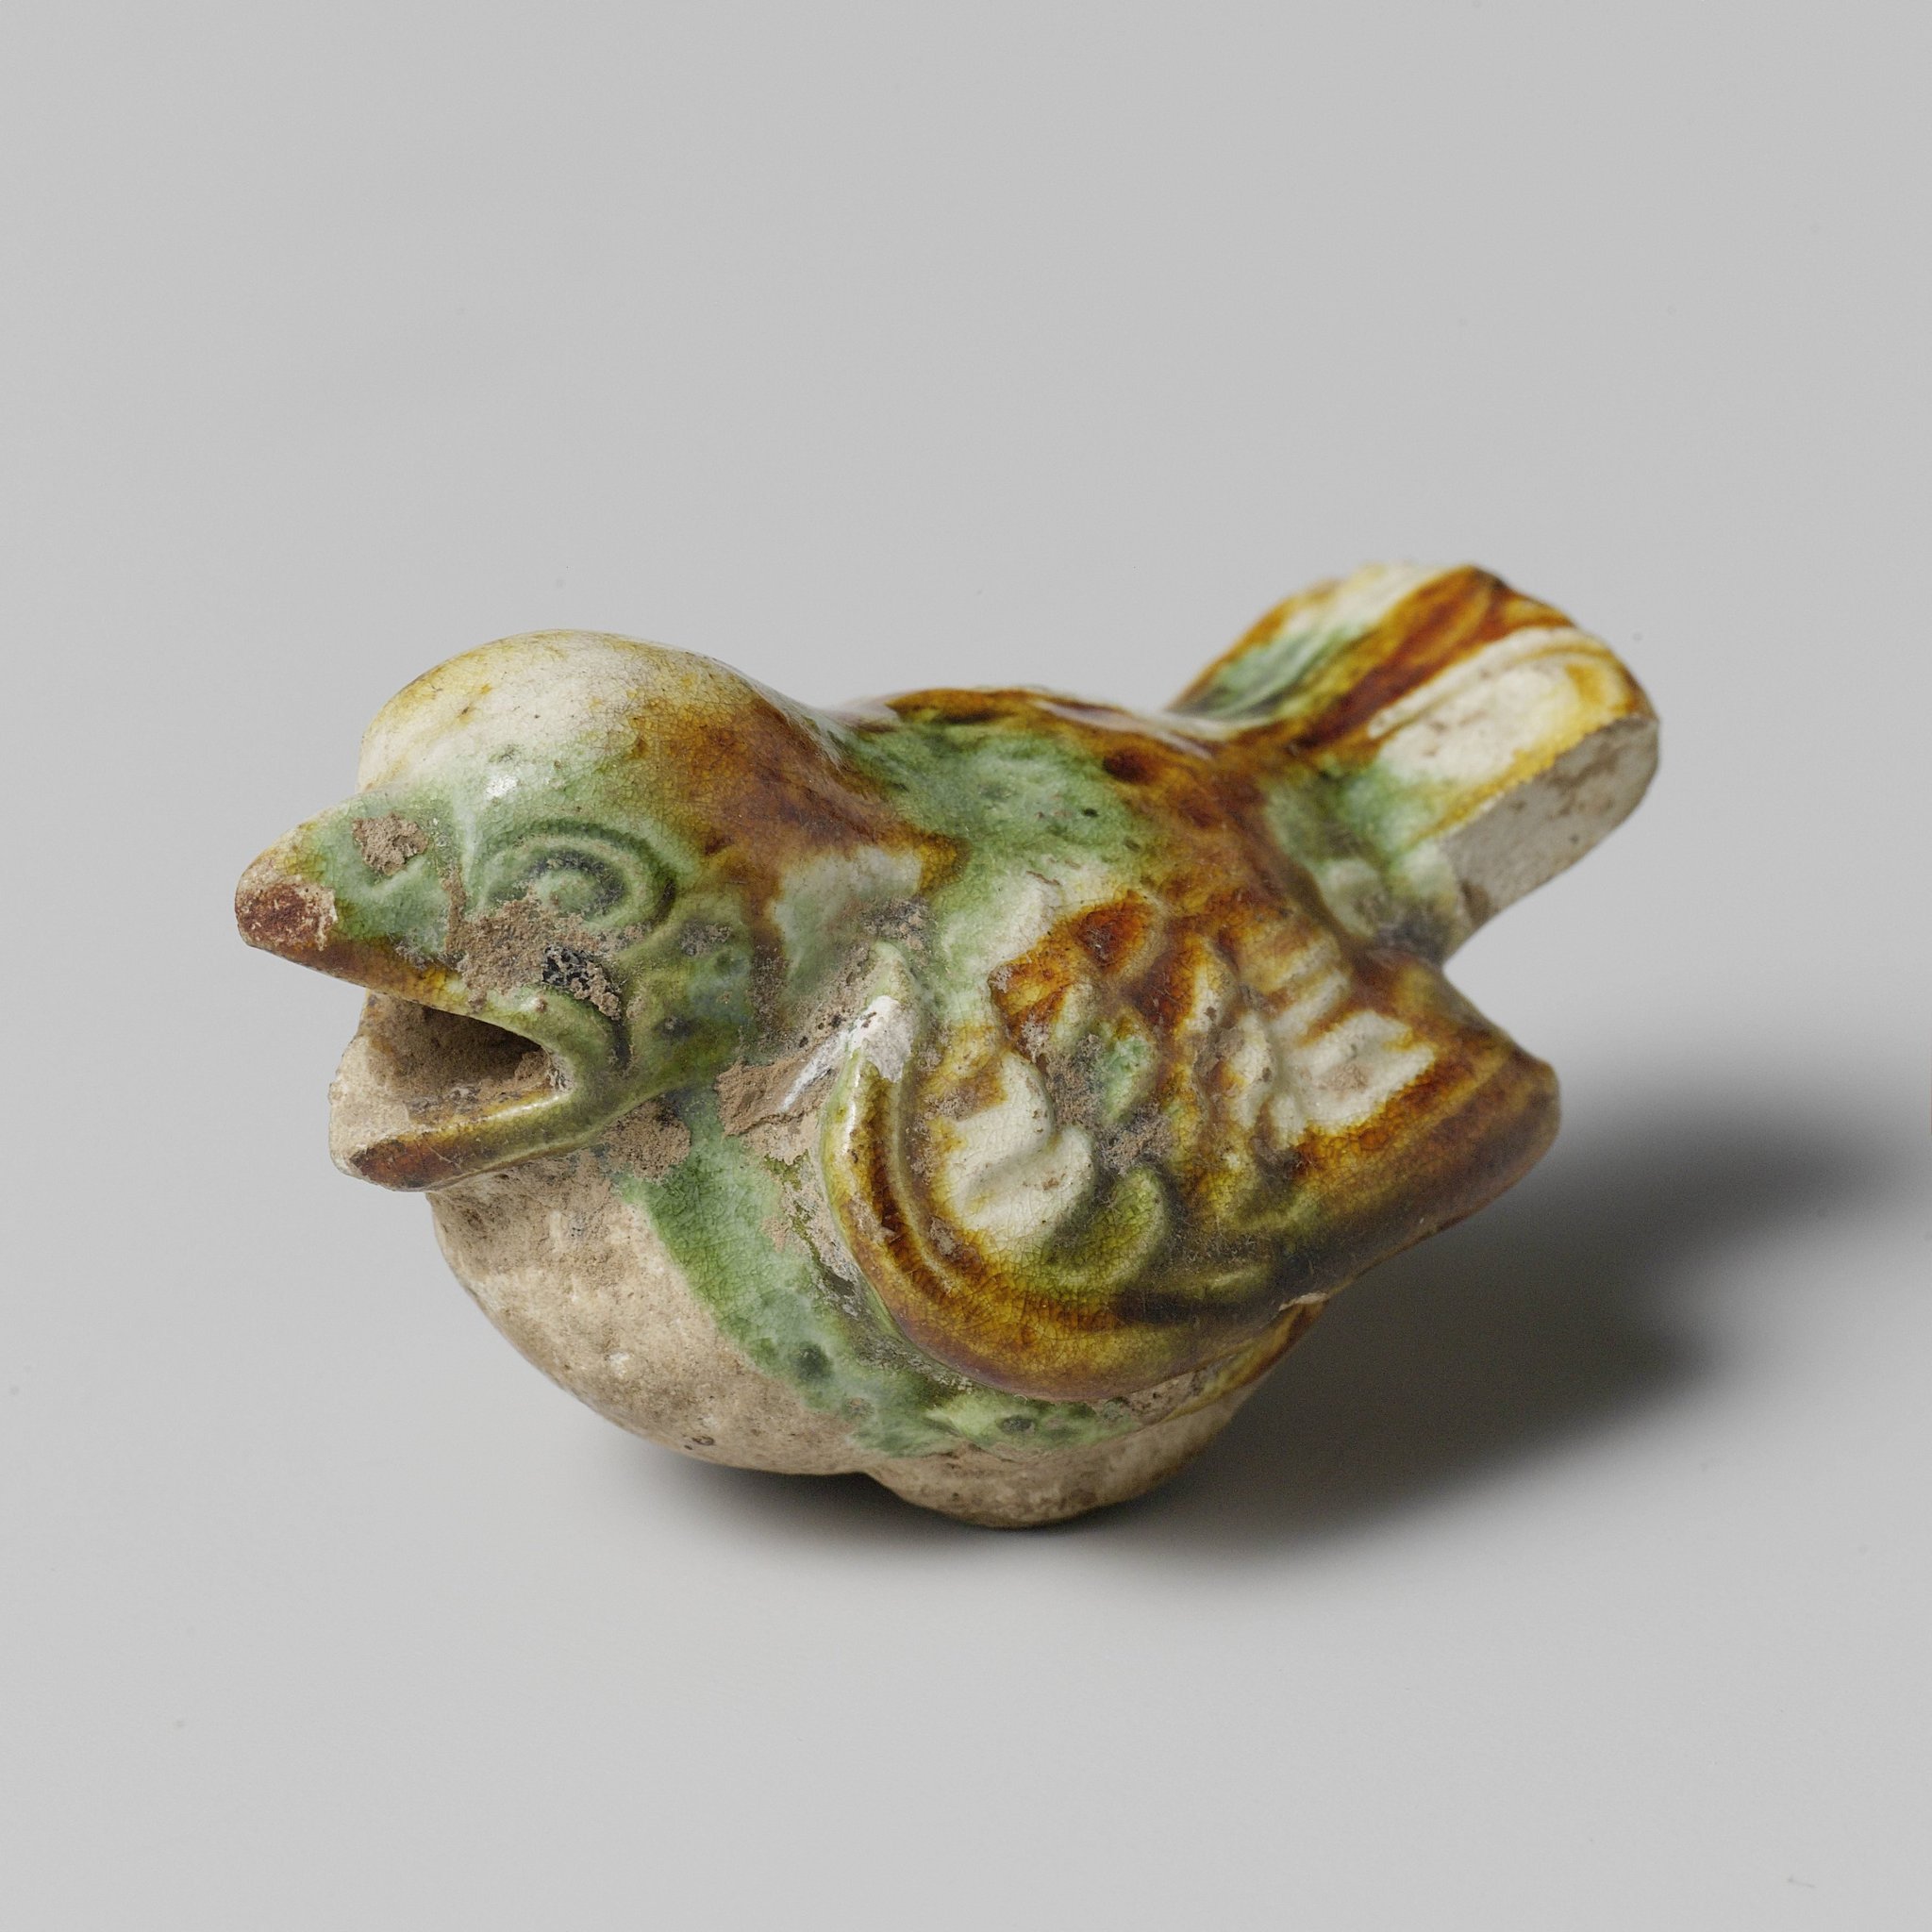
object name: tomb figure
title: Bird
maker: Anonymous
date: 700-750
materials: earthenware, glaze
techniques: firing, turning, vitrification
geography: china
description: Beeld of graffiguur van aardewerk in de vorm van een vogel met geopende bek, bedekt met een crèmekleurig, bruin en groen glazuur. Sancai, Tang.